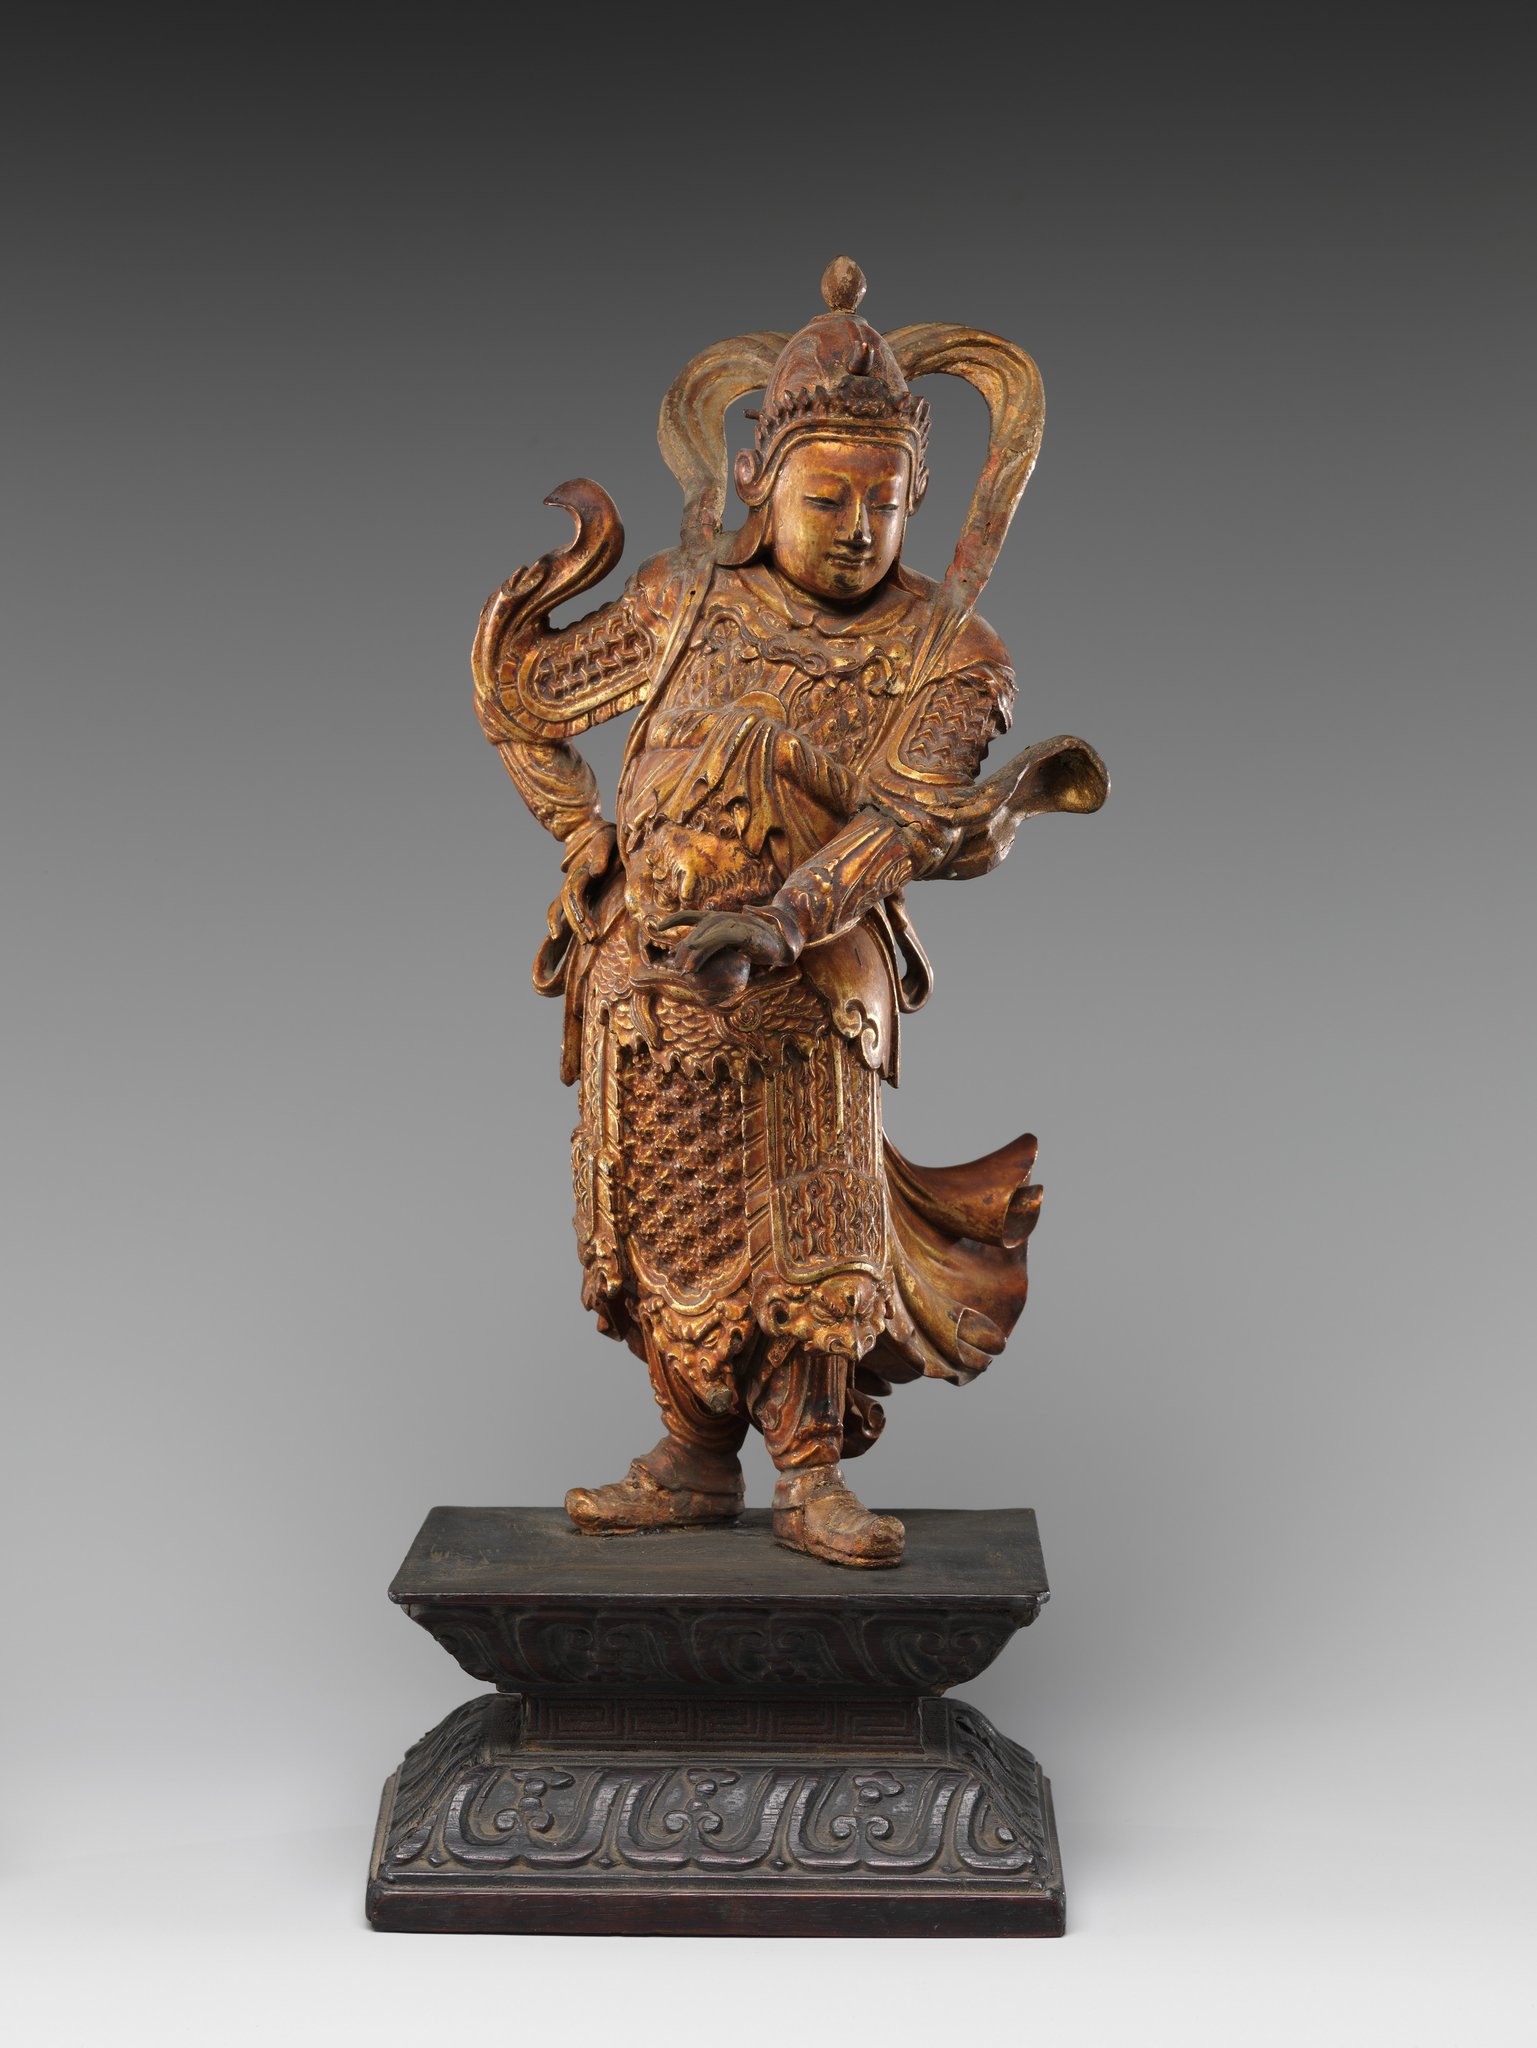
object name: figure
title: Bodhisattva Skanda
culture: chinese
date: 1501-1700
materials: wood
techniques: gilding, lacquer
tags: armor,men